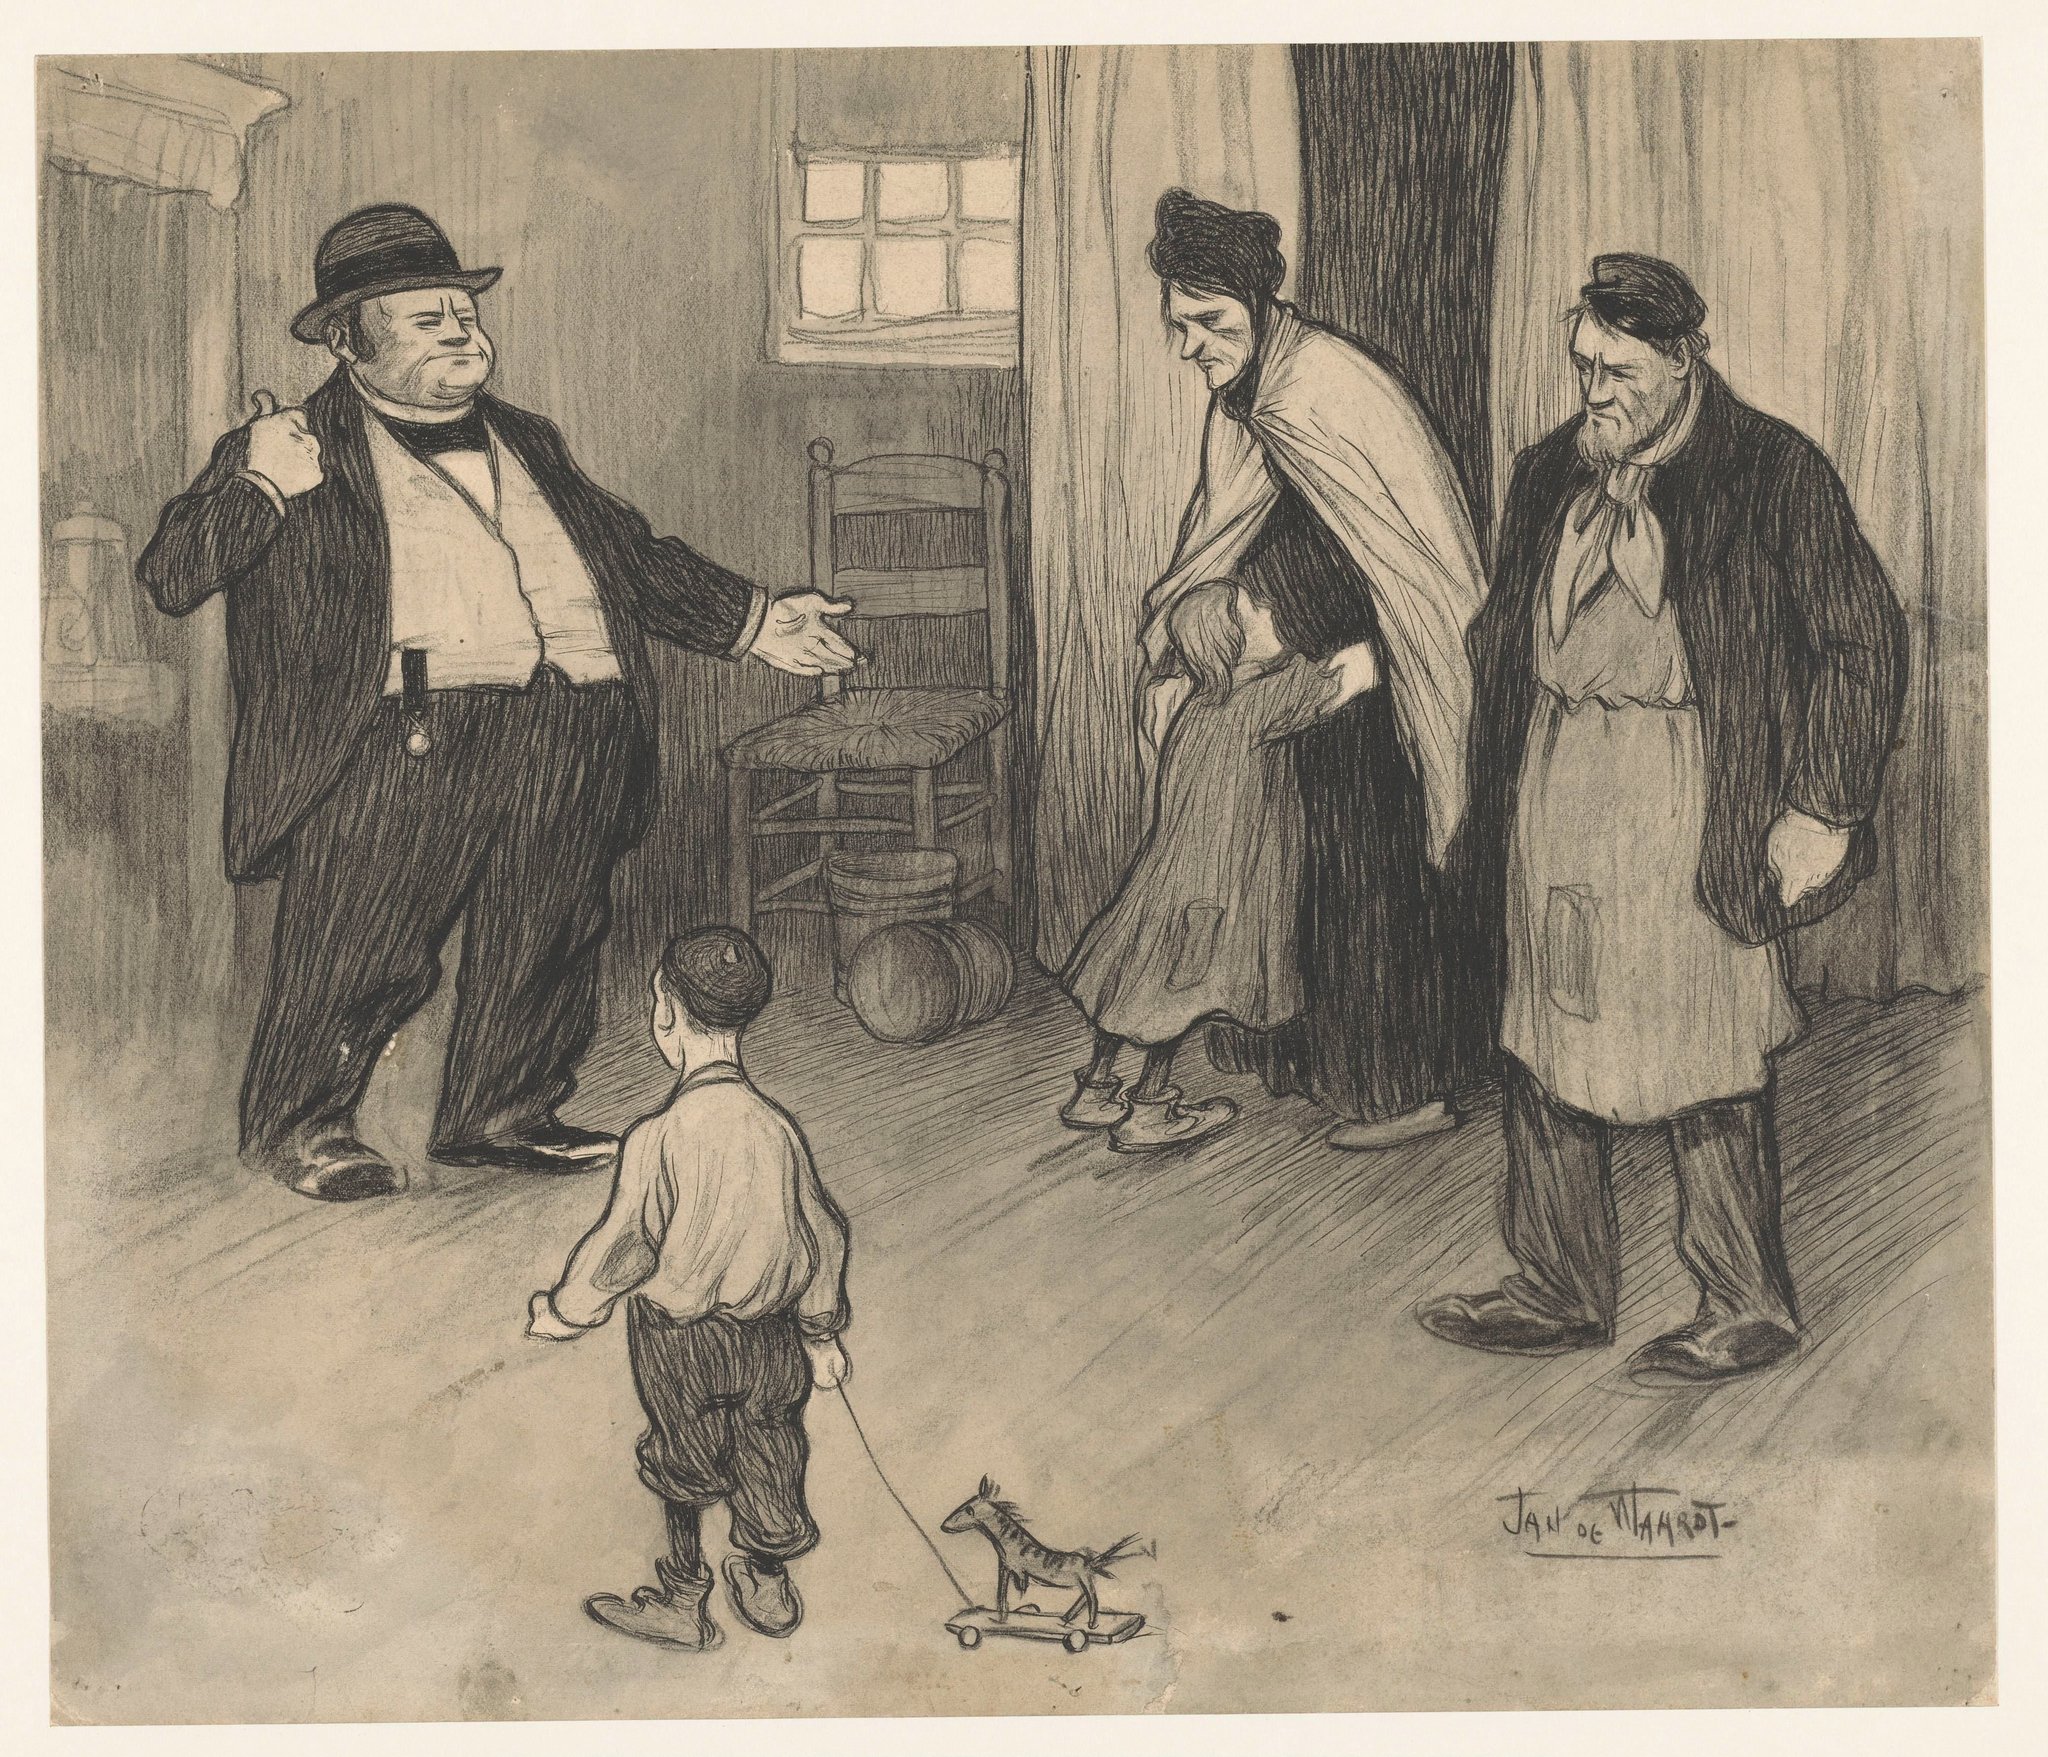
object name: drawing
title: Huisbaas zet gezin uit huis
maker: jan de waardt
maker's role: draughtsman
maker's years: 1871-1909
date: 1885-1909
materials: chalk, paper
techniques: brush, pen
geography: netherlands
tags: bad rich man, good poor man, netherlands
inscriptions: collector's mark: Lugt 2228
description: Huisbaas zet gezin uit huis. Links een dikke man in pak met bolhoed, hij maakt met zijn rechterhand een gebaar over zijn schouder dat zij moeten vertrekken. Rechts een verslagen arme familie. Een klein meisje klampt zich vast aan haar moeder, een vrouw met zwarte muts. Rechts de staat de vader, een man met schort en muts. Op de voorgrond een jongetje, op de rug gezien, met een speelgoedpaardje op wieltjes.